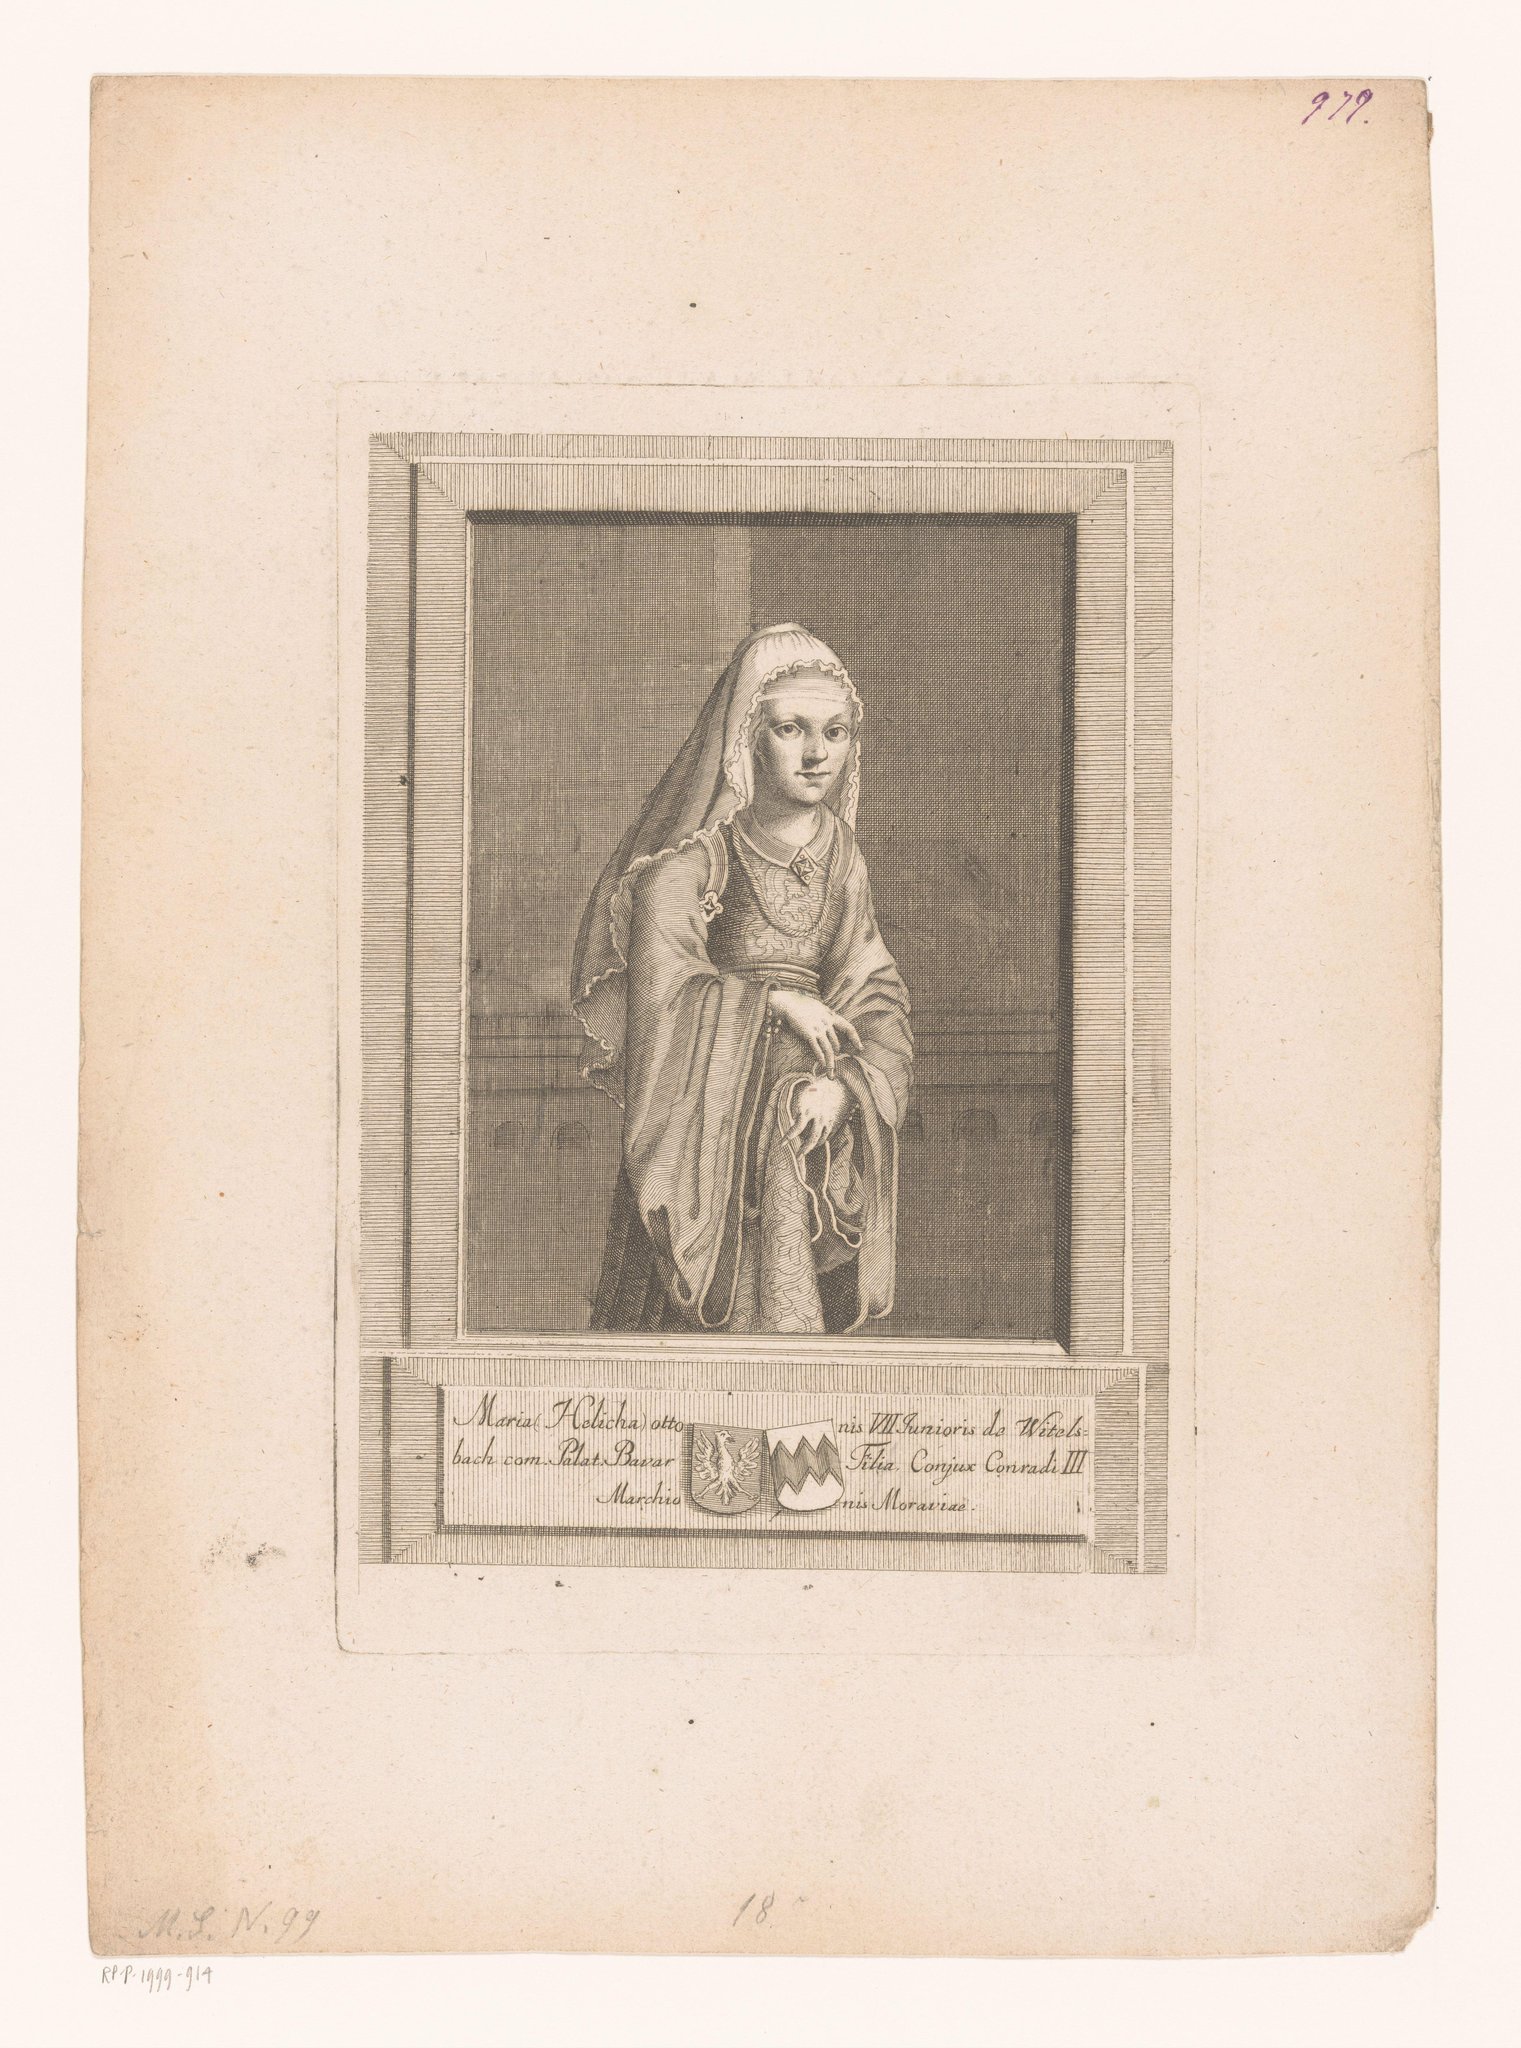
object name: print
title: Portret van Hellicha van Wittelsbach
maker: joseph anton zimmermann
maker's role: draughtsman, print maker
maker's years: 1705-1797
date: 1773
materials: paper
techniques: engraving, etching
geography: germany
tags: historical persons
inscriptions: collector's mark: Lugt 2228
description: Prent gebruikt voor de publicatie: Zimmermann, Joseph Anton. Series Imaginum Augustae Domus Boicae. München: s.n., 1773.